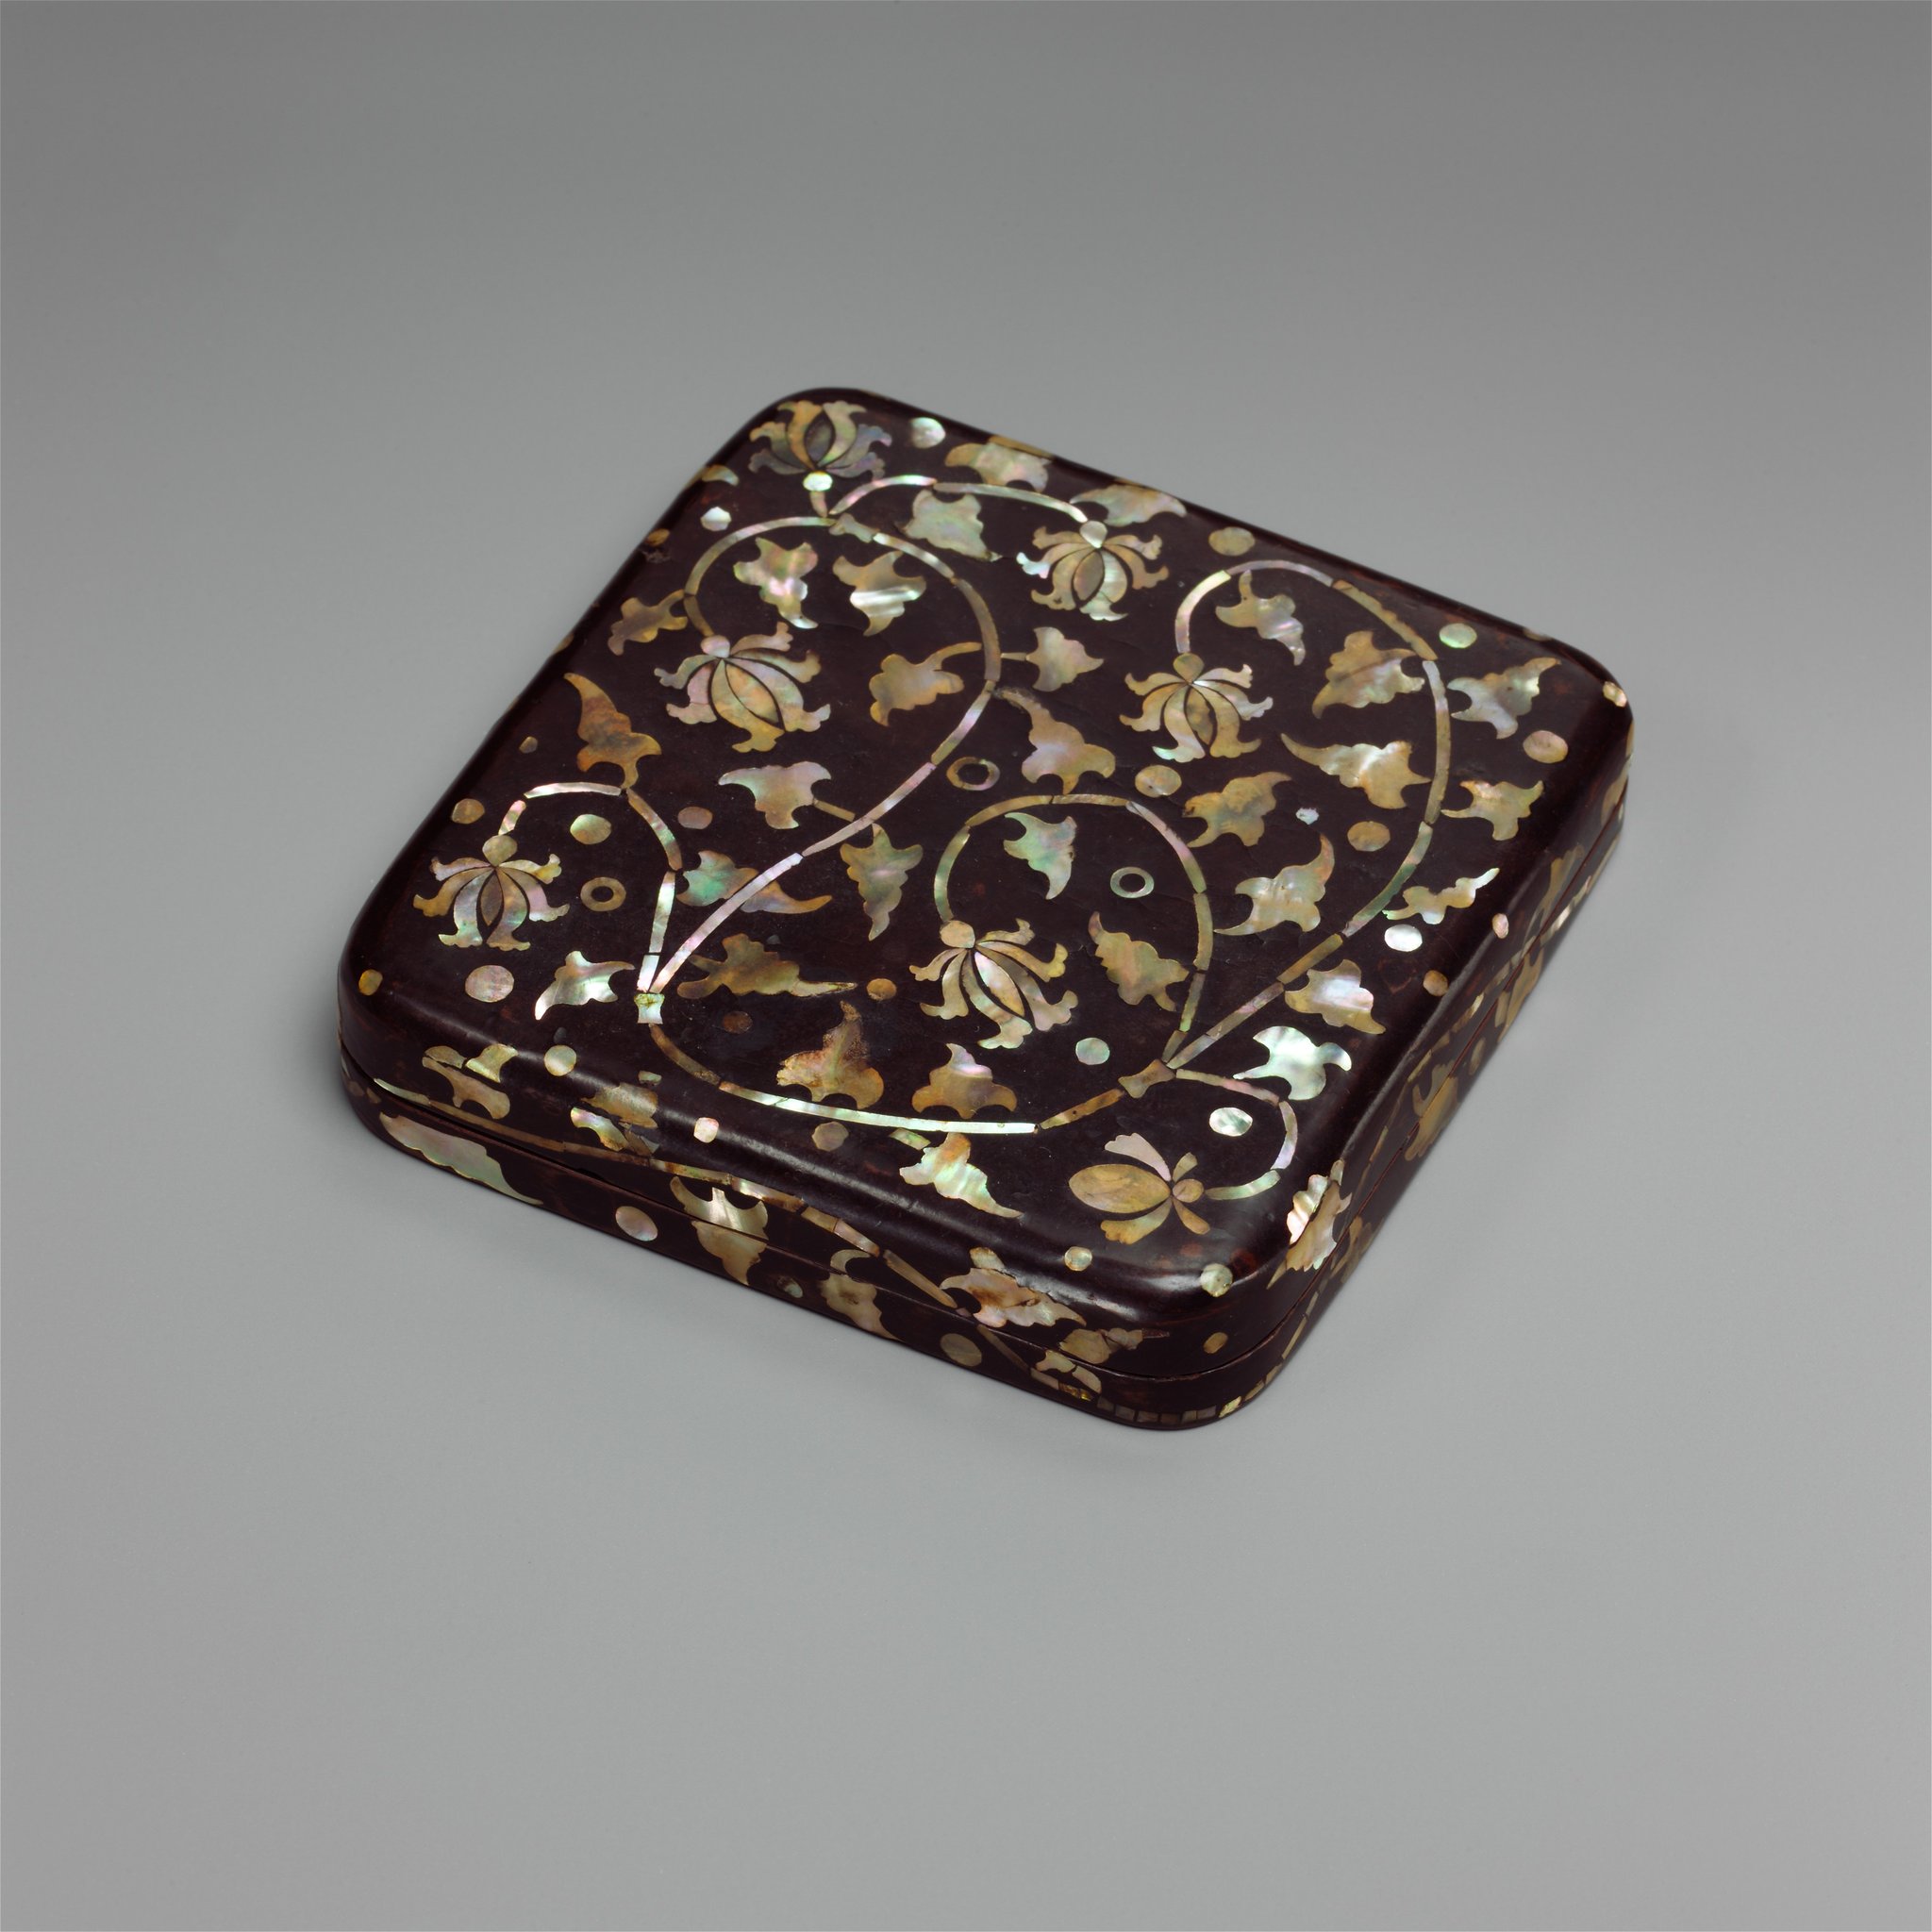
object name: box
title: Box with decoration of peony scrolls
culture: korean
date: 1401-1600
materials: lacquer, mother of pearl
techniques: inlay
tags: peonies